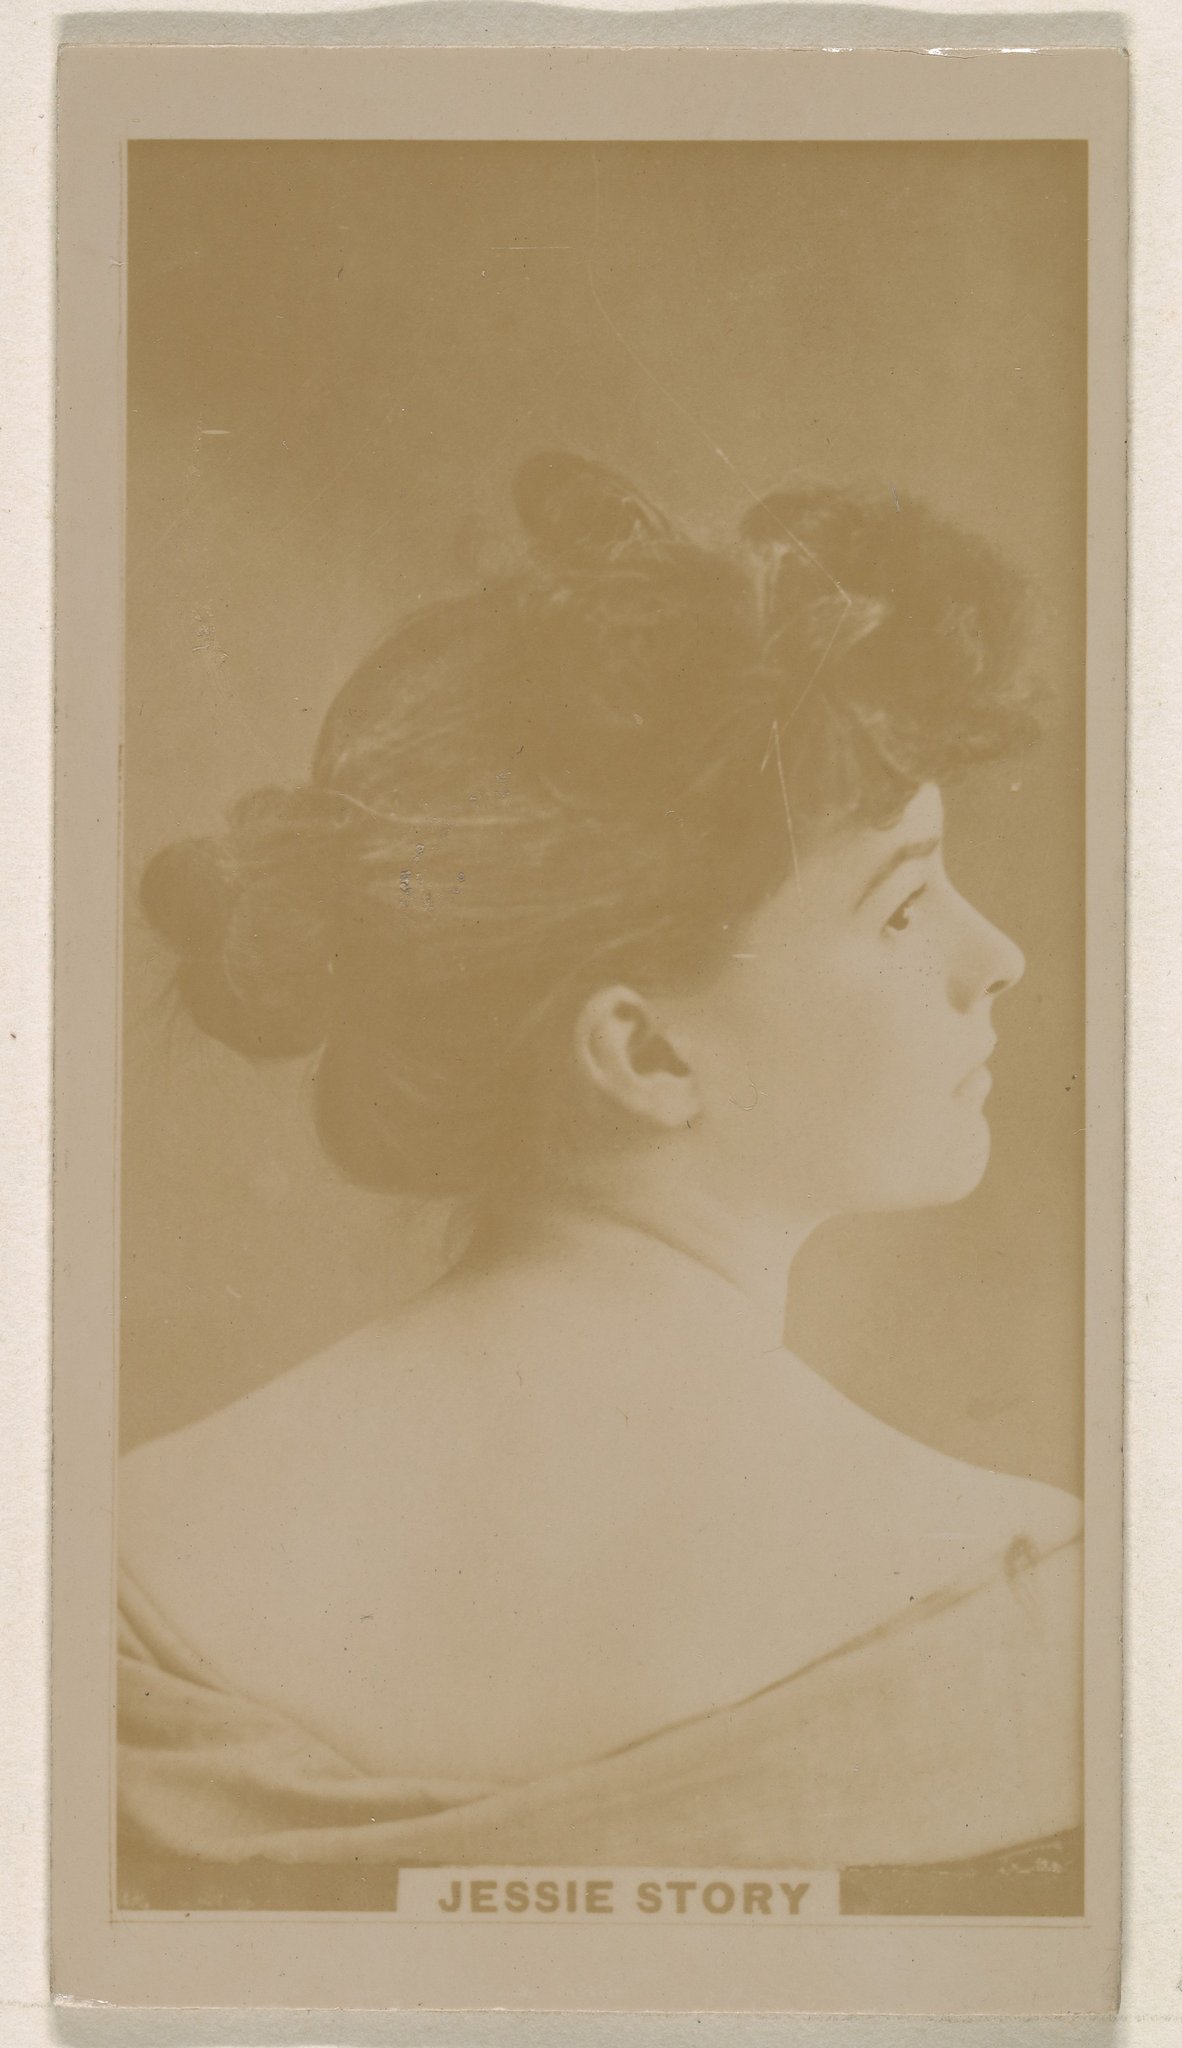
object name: photograph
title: Jessie Story, from the Actresses series (N245) issued by Kinney Brothers to promote Sweet Caporal Cigarettes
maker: kinney brothers tobacco company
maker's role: publisher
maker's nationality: american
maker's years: 1869-2011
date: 1890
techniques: albumen silver print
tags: women,actresses